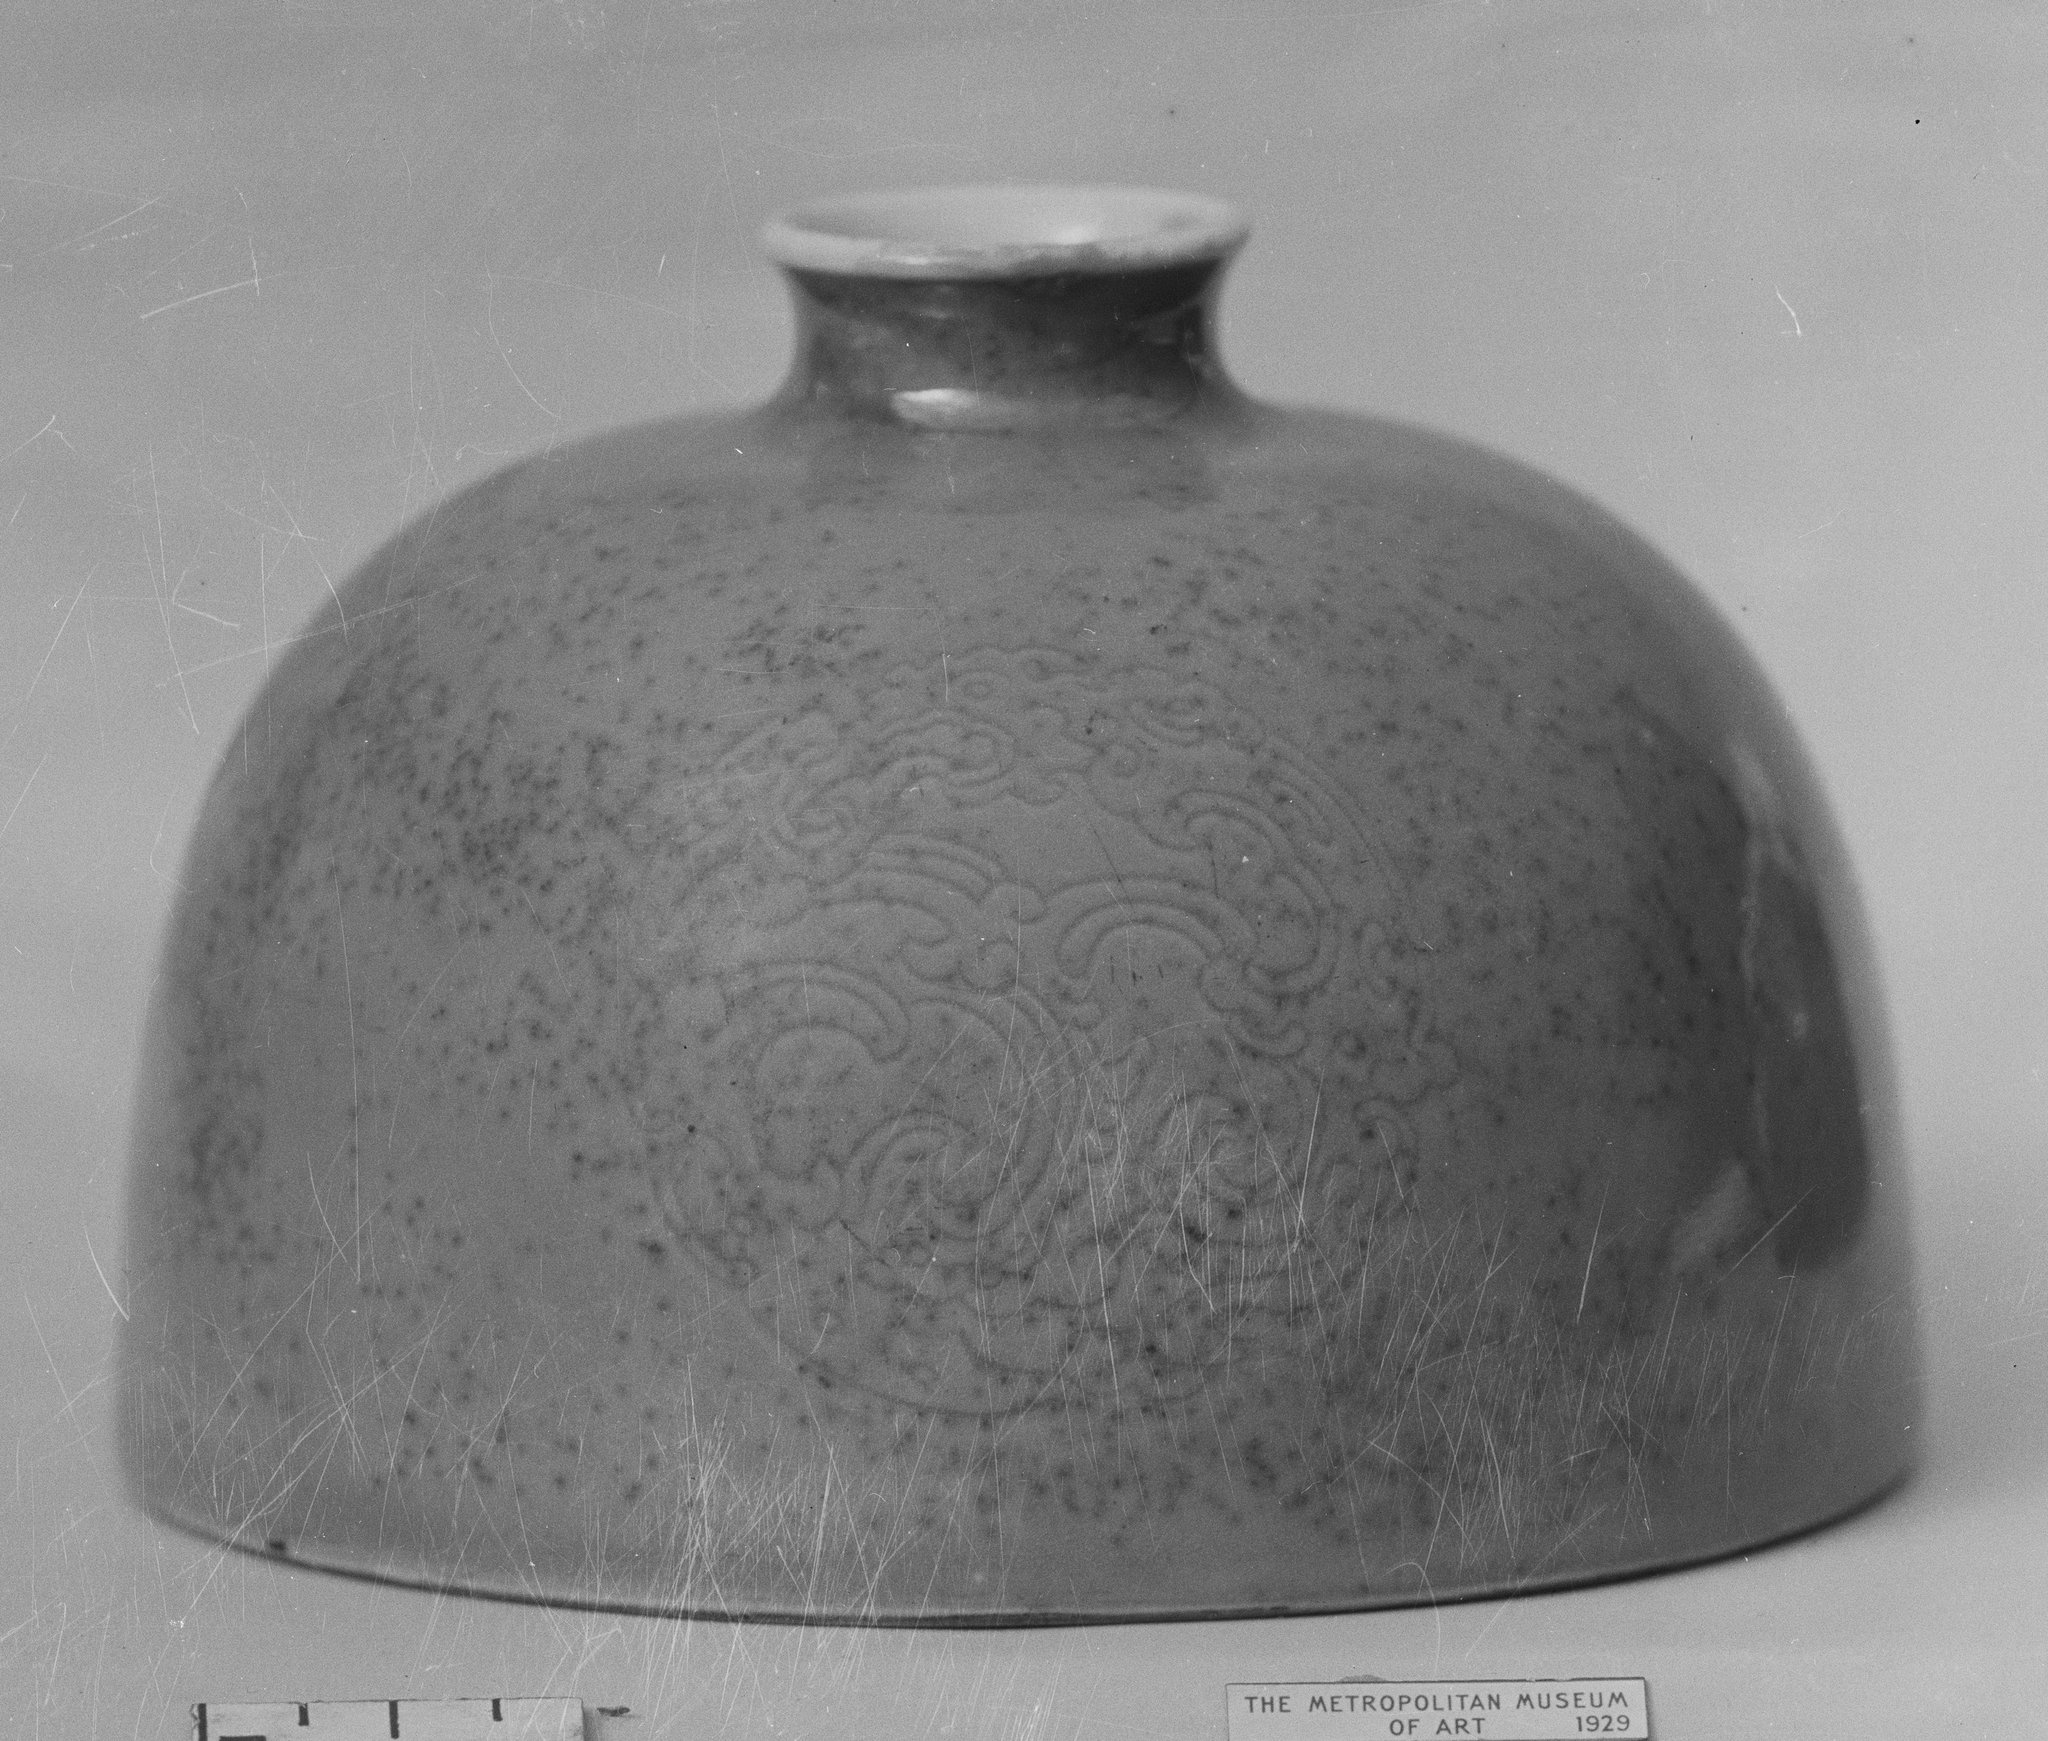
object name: water coupe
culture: chinese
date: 1662-1722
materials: glaze, porcelain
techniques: incising